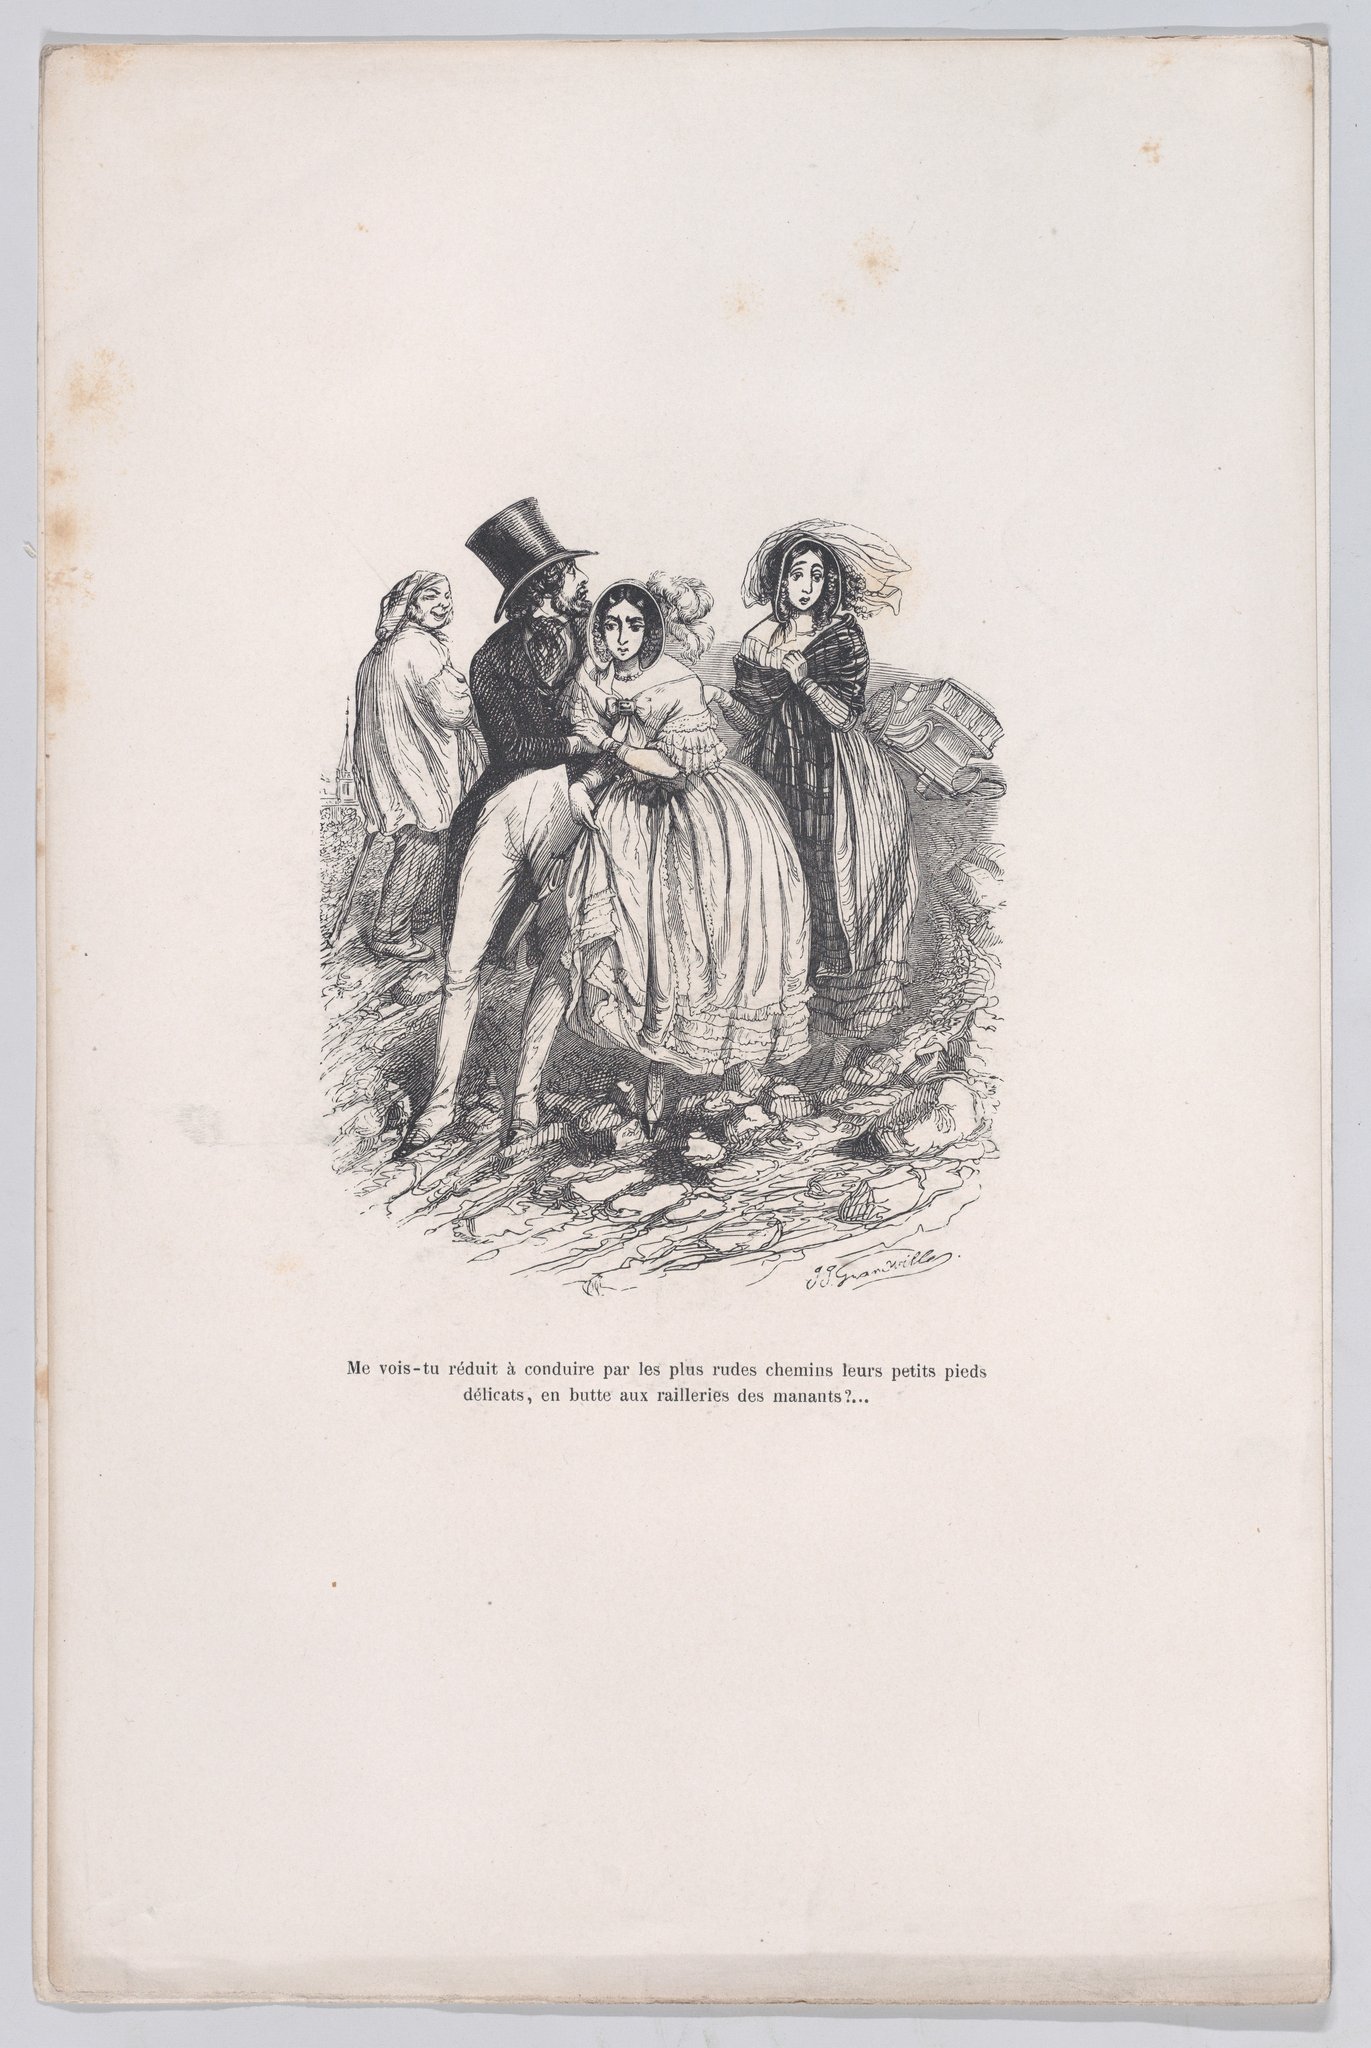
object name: print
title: Do you see me reduced to driving by the roughest paths their little delicate feet, in the grip of the mockery of the leaders?, from "Little Miseries of Human Life"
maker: j. j. grandville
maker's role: illustrator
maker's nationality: french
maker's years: 1803-1847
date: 1843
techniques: engraving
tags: men,women